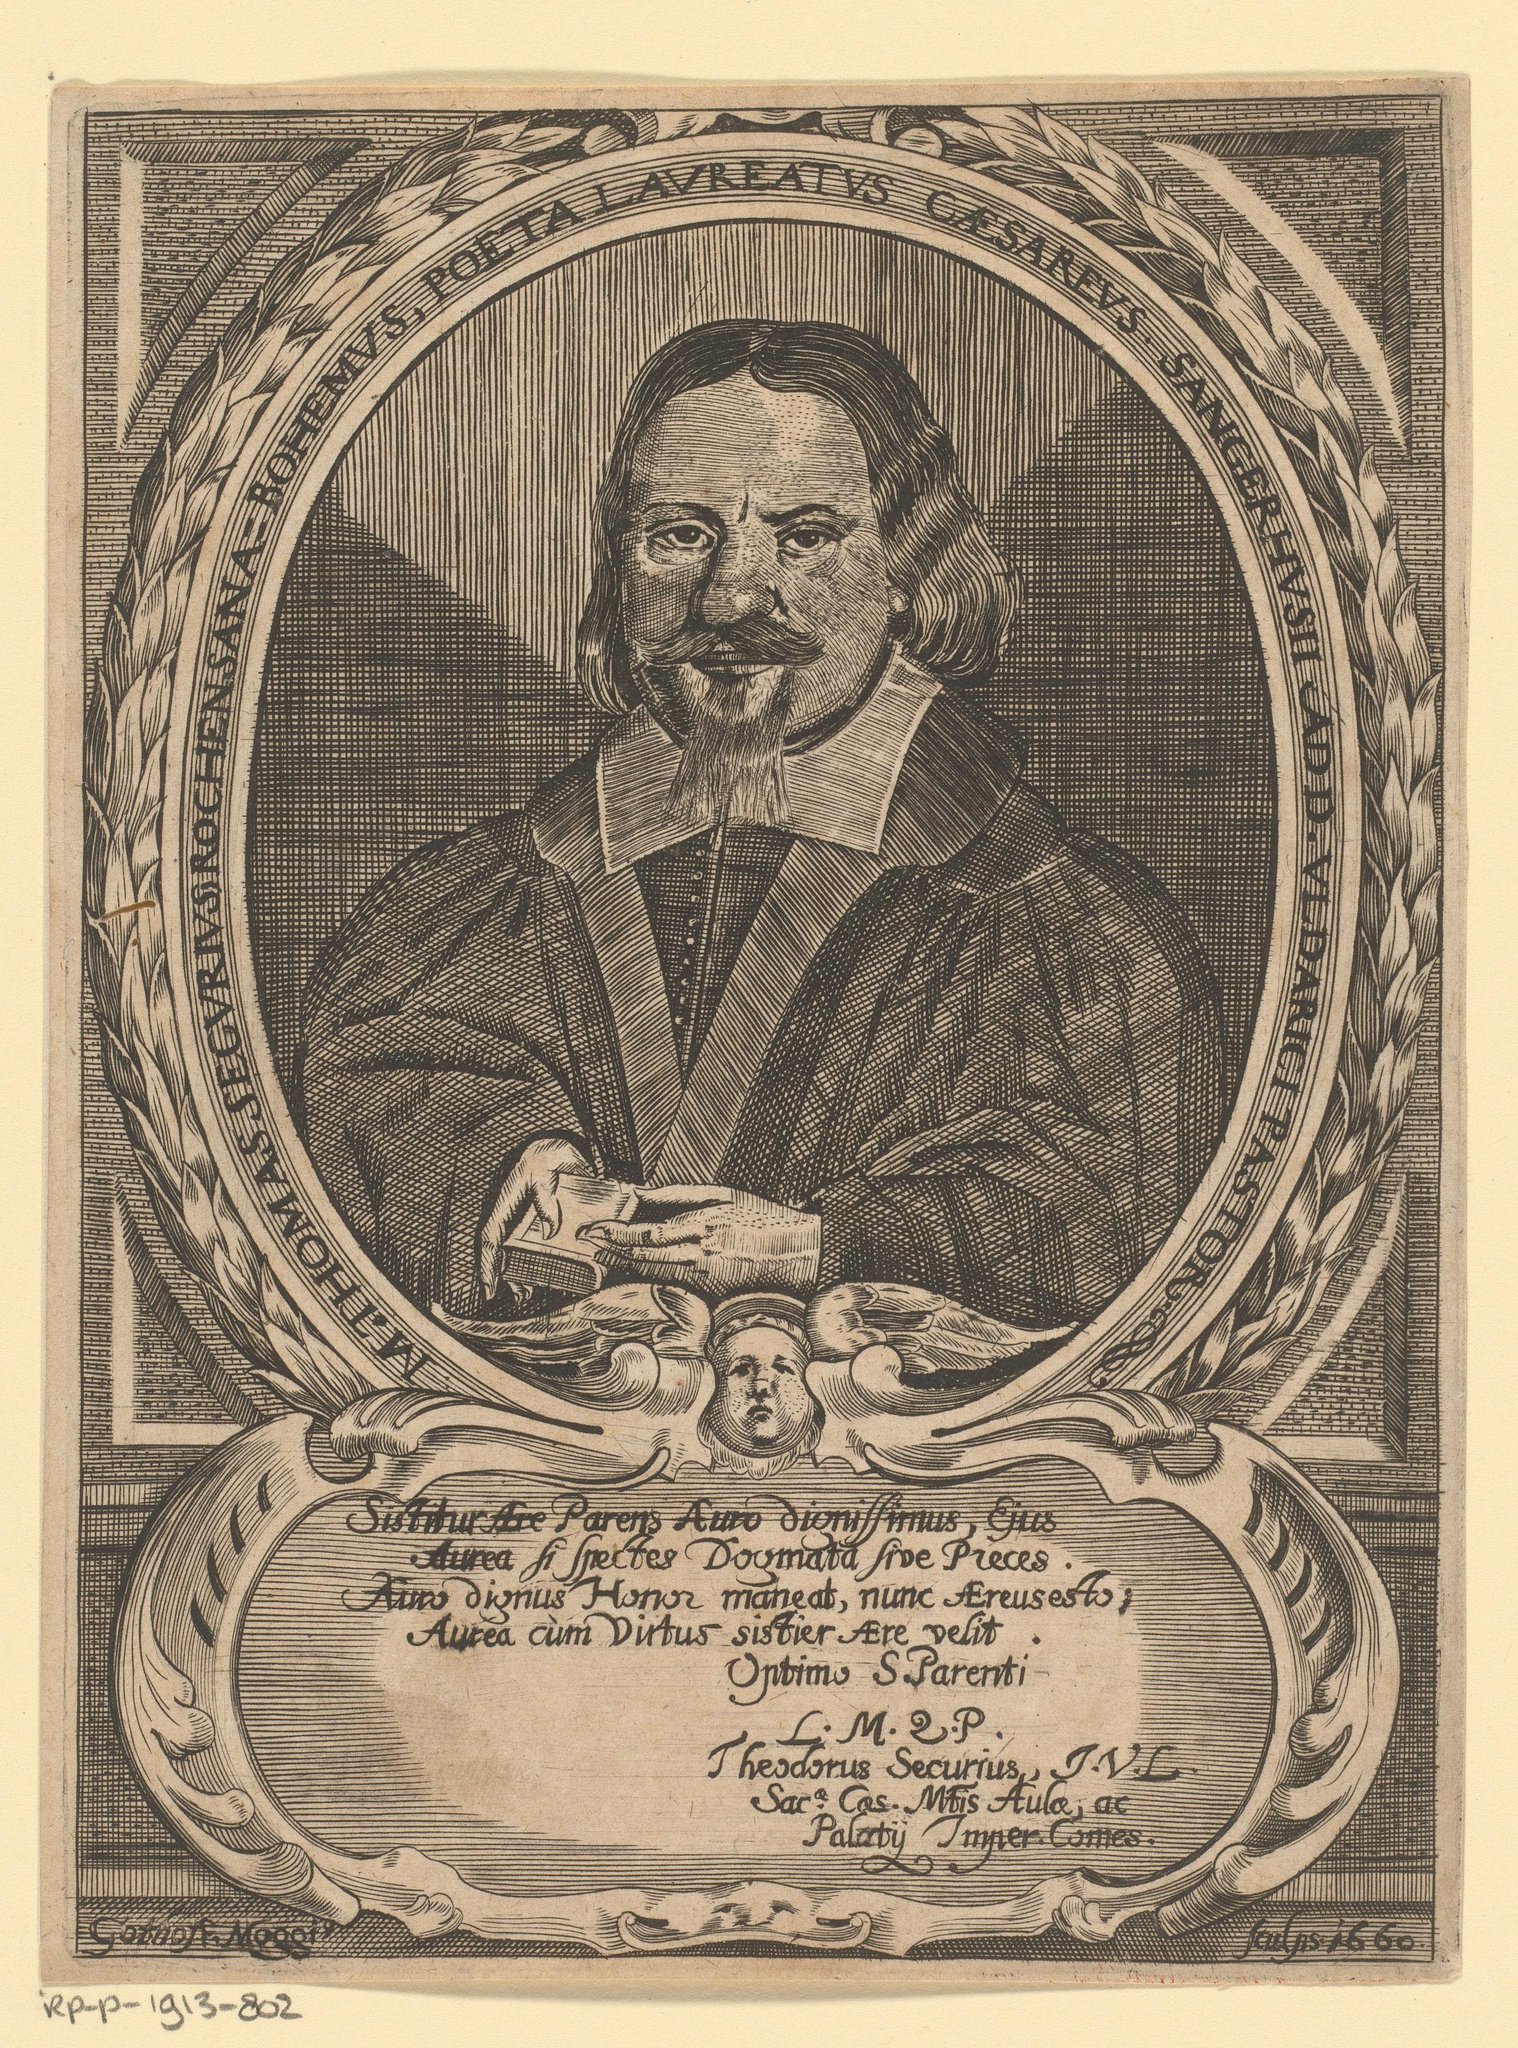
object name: print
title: Portret van Thomas Securius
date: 1660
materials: paper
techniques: engraving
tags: historical persons, functionaries and dignitaries (with name) ~ episcopal protestant churches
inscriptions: collector's mark: Lugt 2228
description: Met vierregelig onderschrift in het Latijn en tekst in het Latijn rondom het portret.